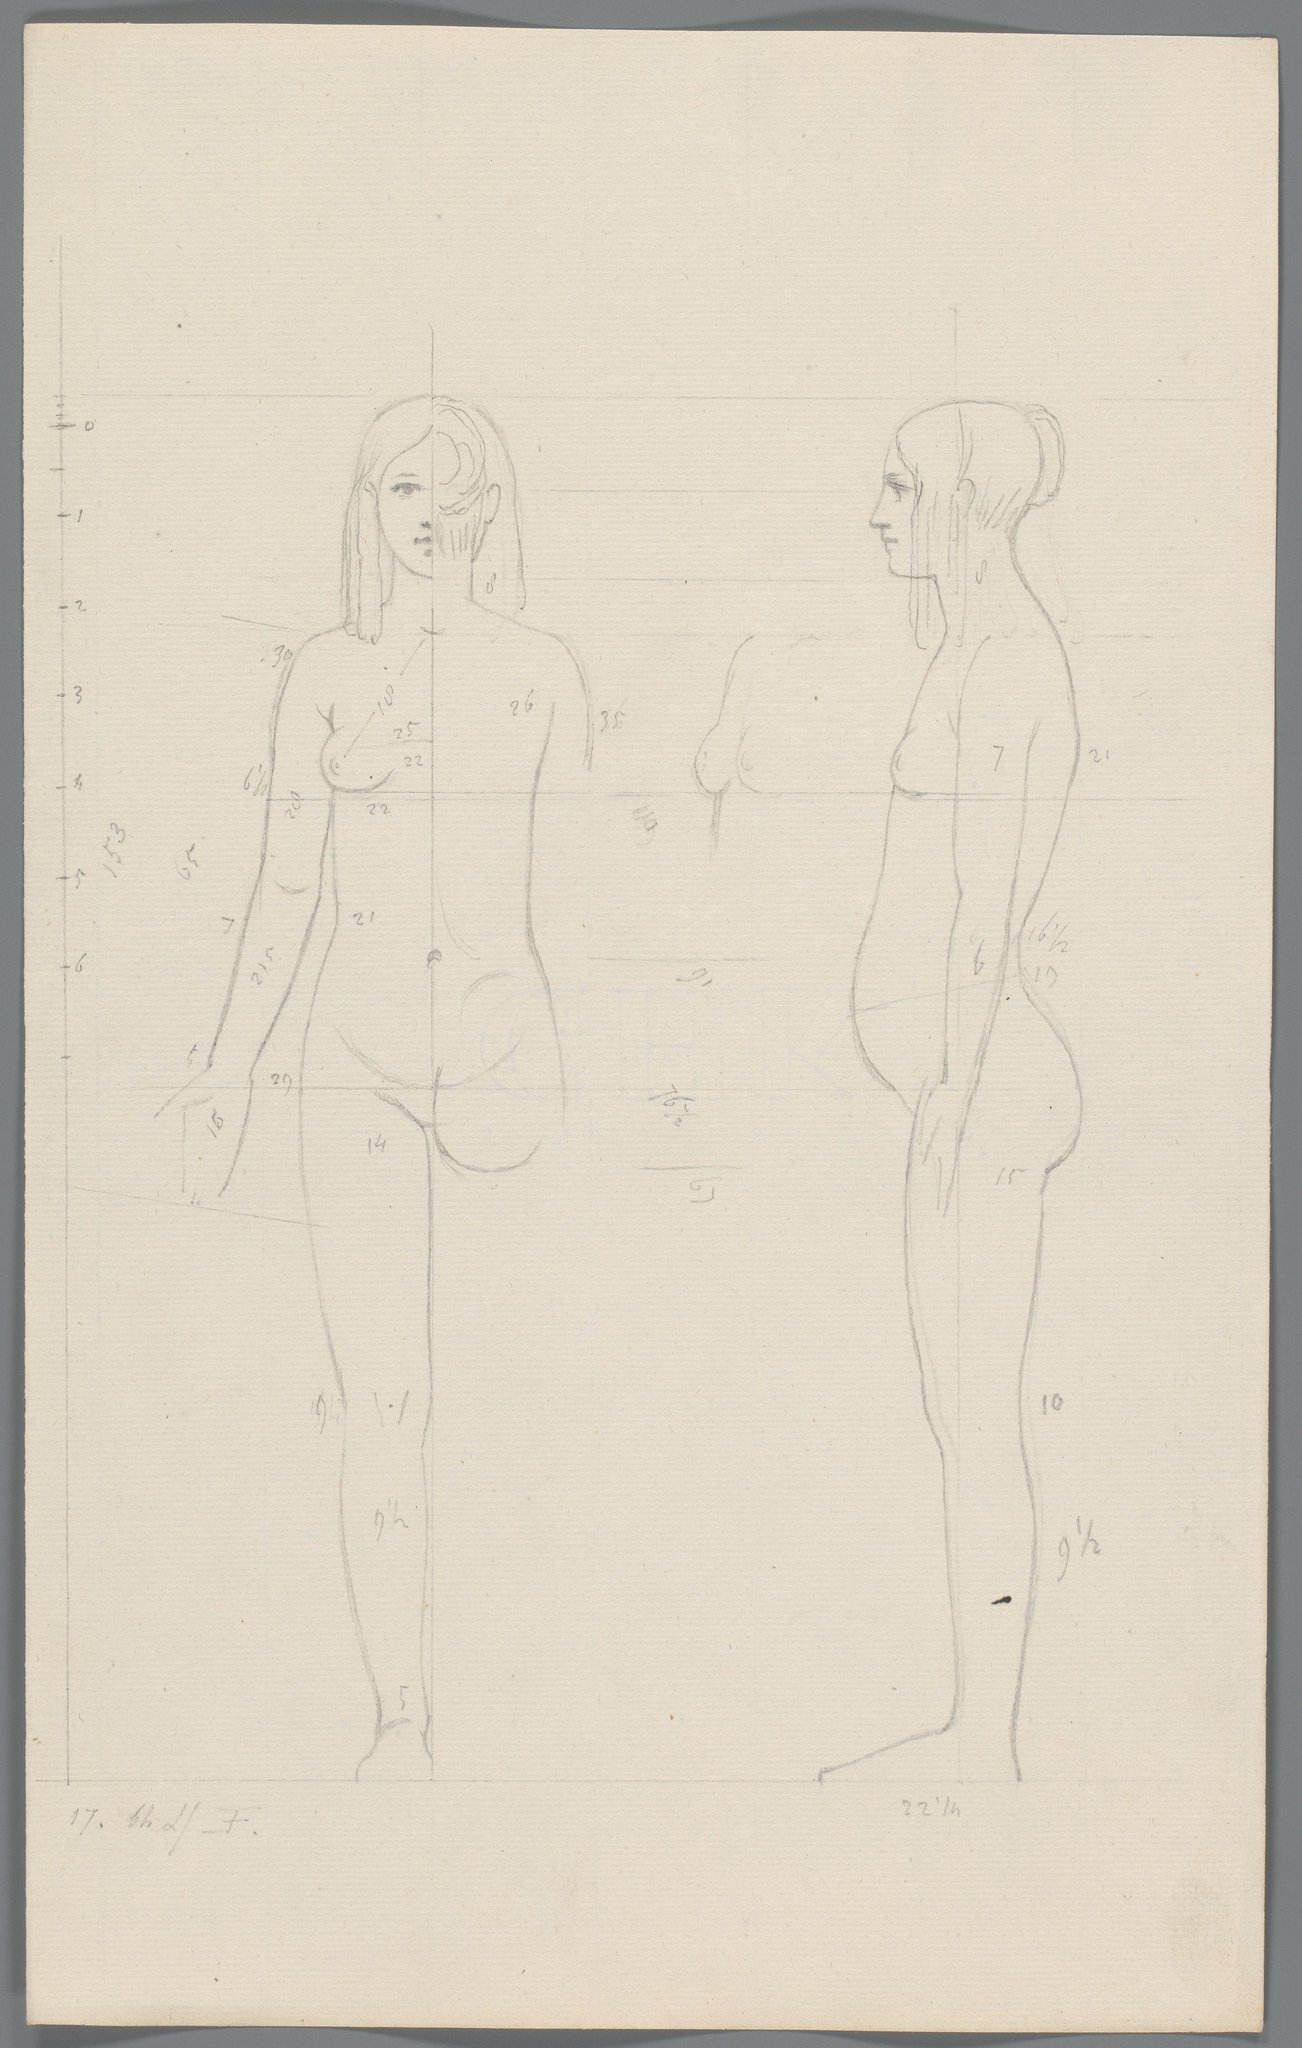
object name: drawing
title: Proportiestudie van een vrouw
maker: jacobus everhardus josephus van den berg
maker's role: draughtsman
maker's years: 1802-1861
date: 1856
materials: paper, pencil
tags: standing figure (canon, proportions) - aa - female human figure, anatomy (non-medical) - aa - female human figure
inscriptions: inscription: ‘17 bh lf EF.’